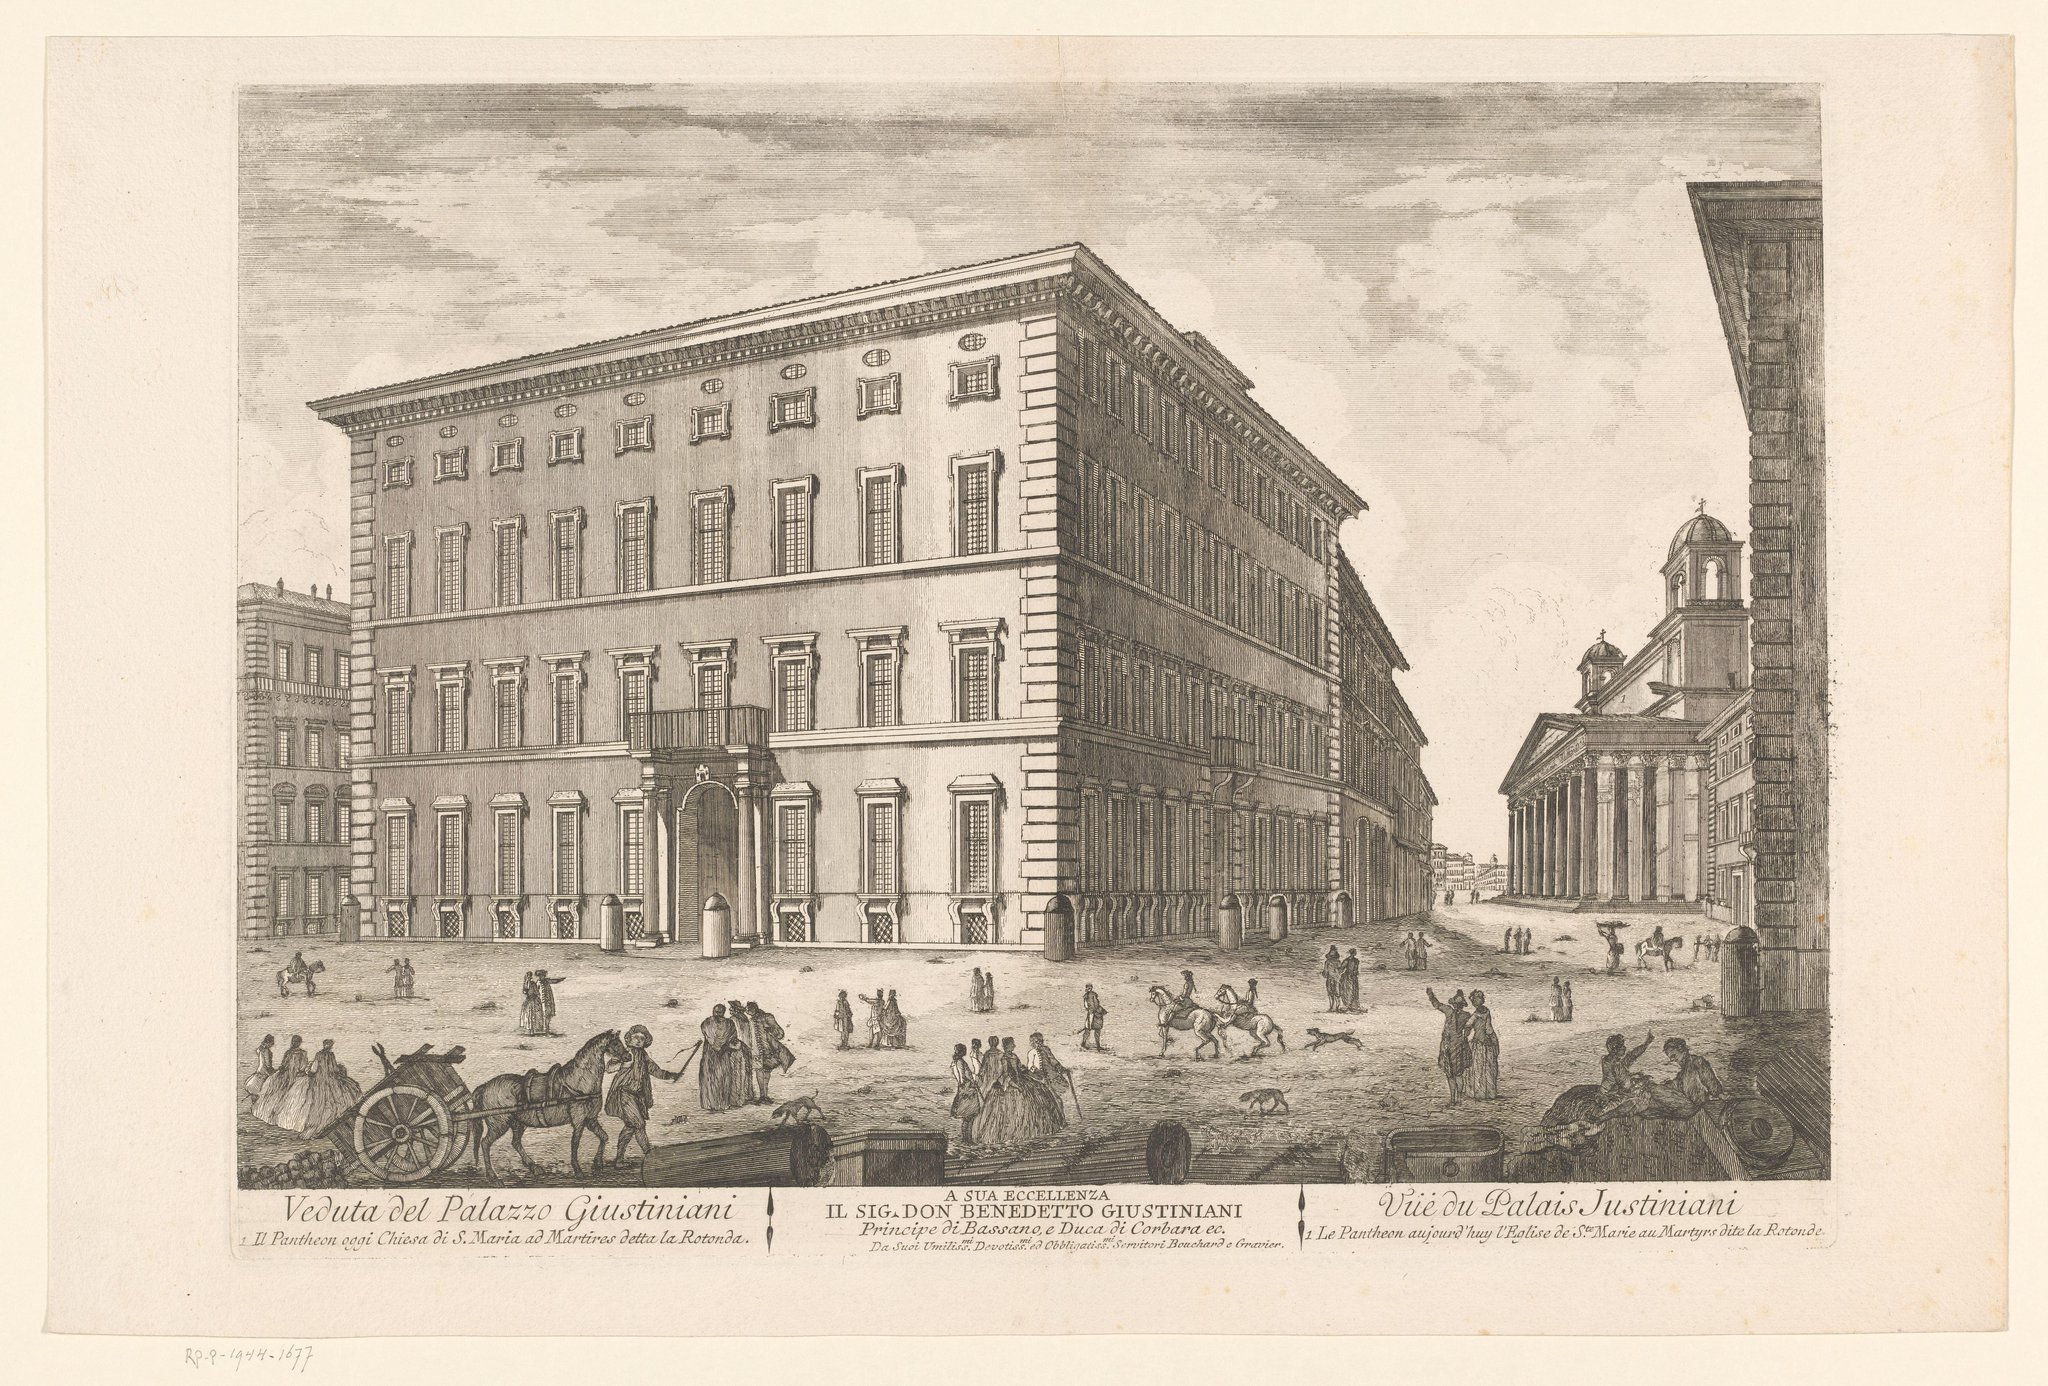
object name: print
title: Veduta del Palazzo Giustiniani / Vuë du Palais Justiniani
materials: paper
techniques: engraving, etching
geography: rome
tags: palace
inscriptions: collector's mark: Lugt 2228